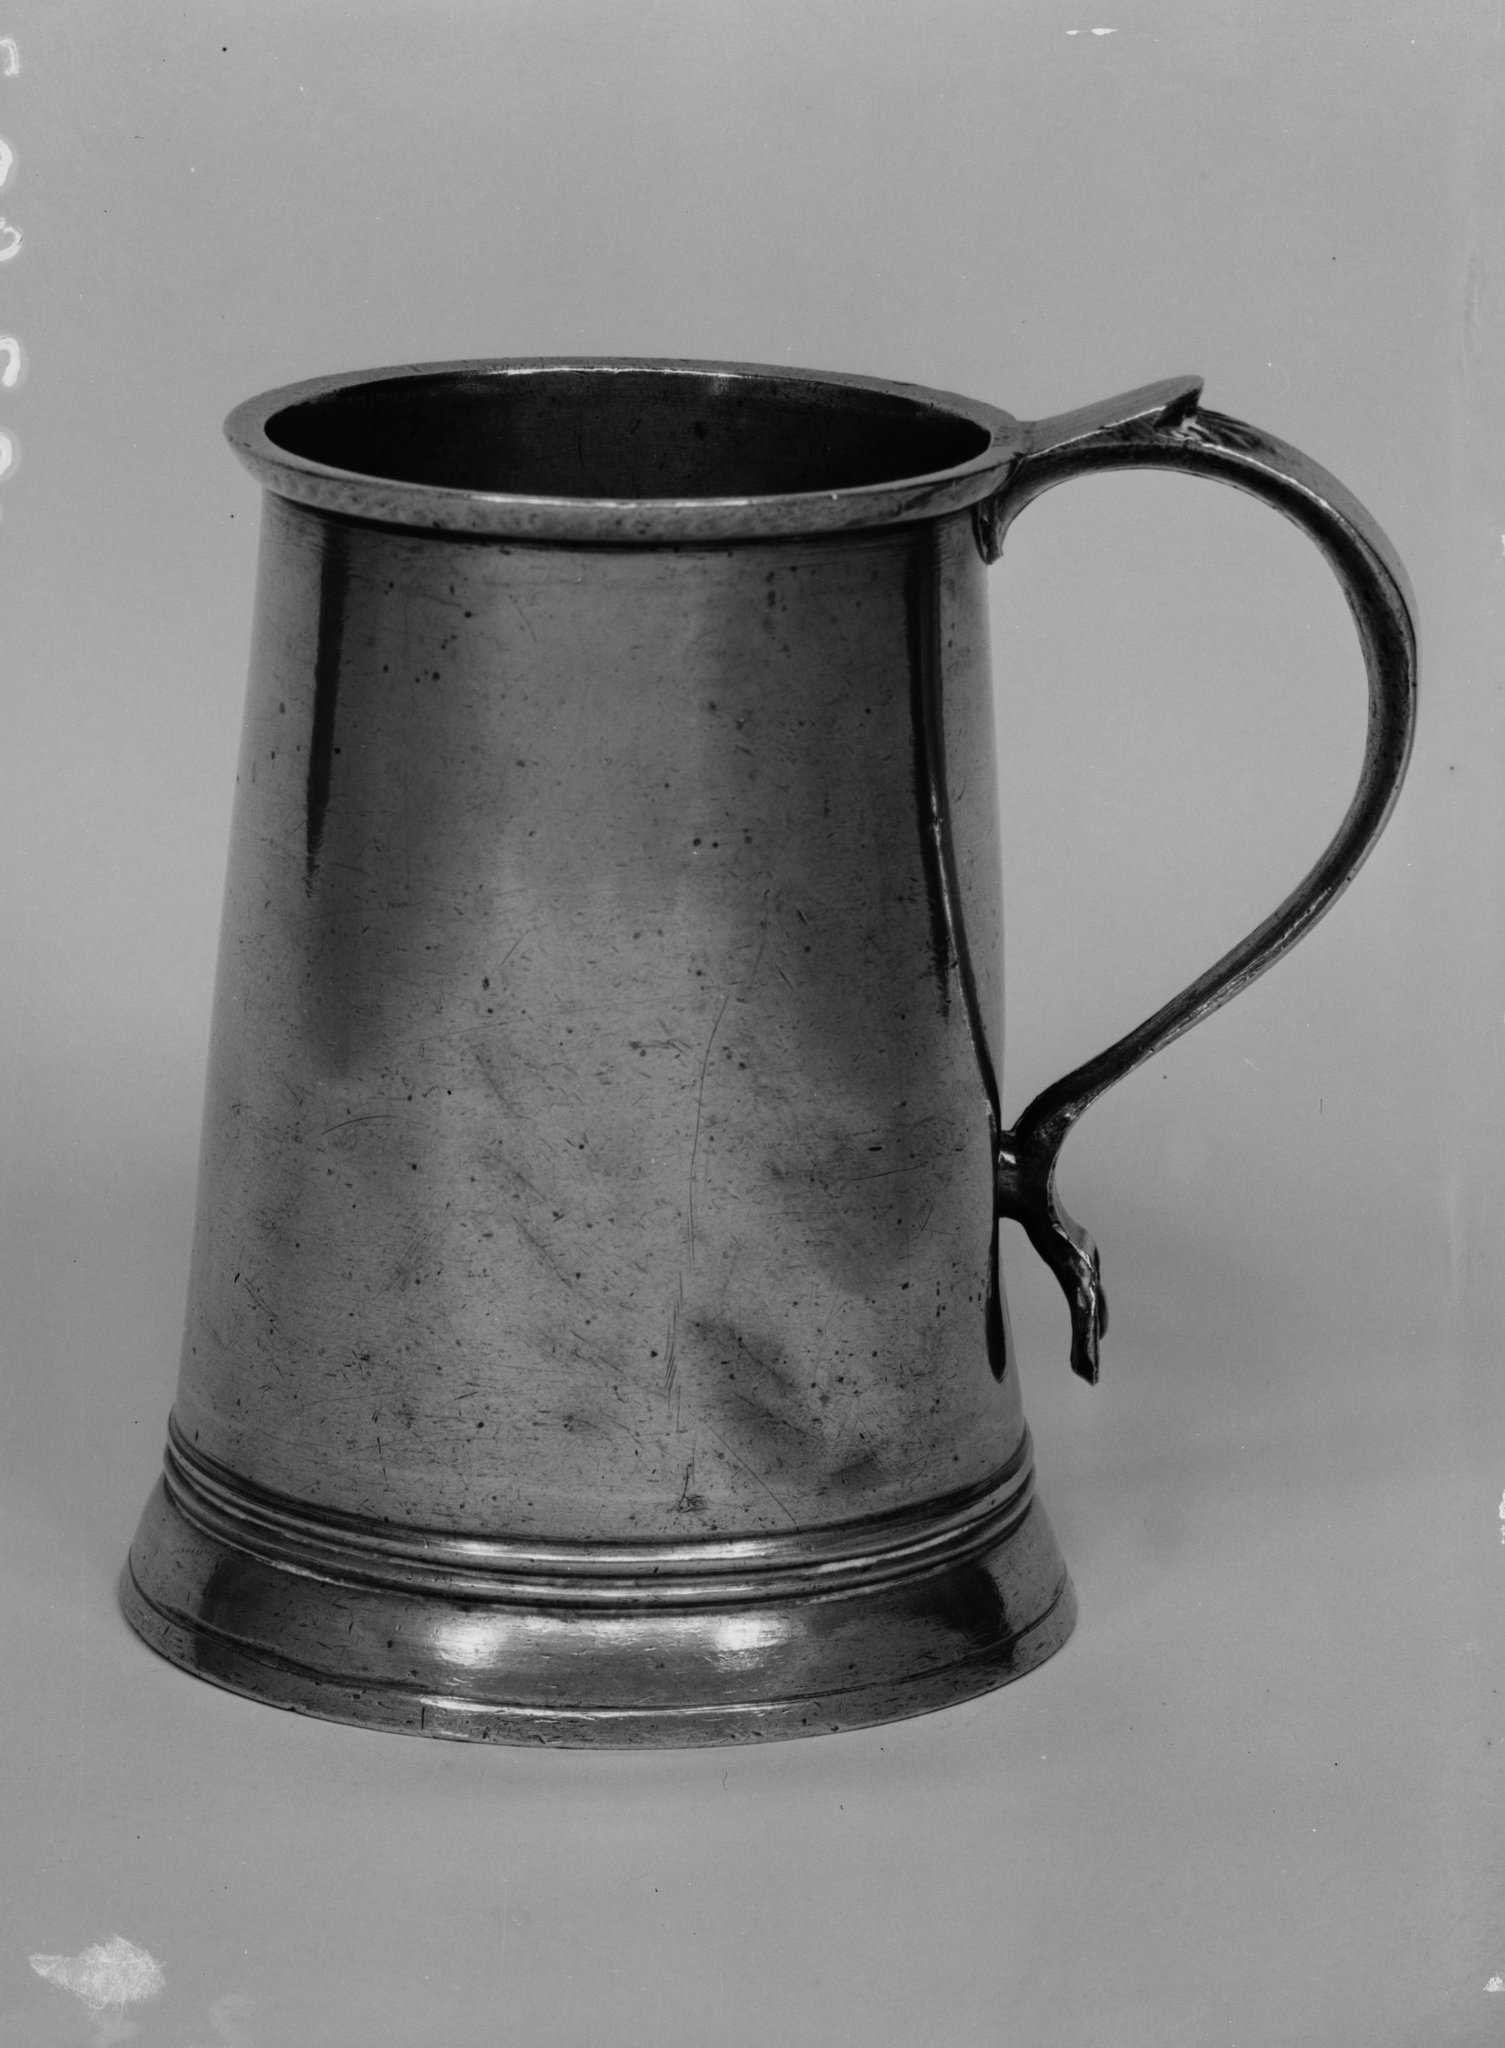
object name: mug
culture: american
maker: nathaniel austin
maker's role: maker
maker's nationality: american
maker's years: 1741-1816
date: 1763-1807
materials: pewter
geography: united states